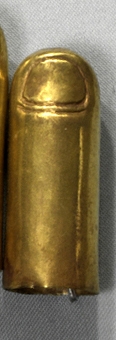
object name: finger stall, group 2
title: Finger stall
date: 1479-1425 BCE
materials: gold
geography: egypt